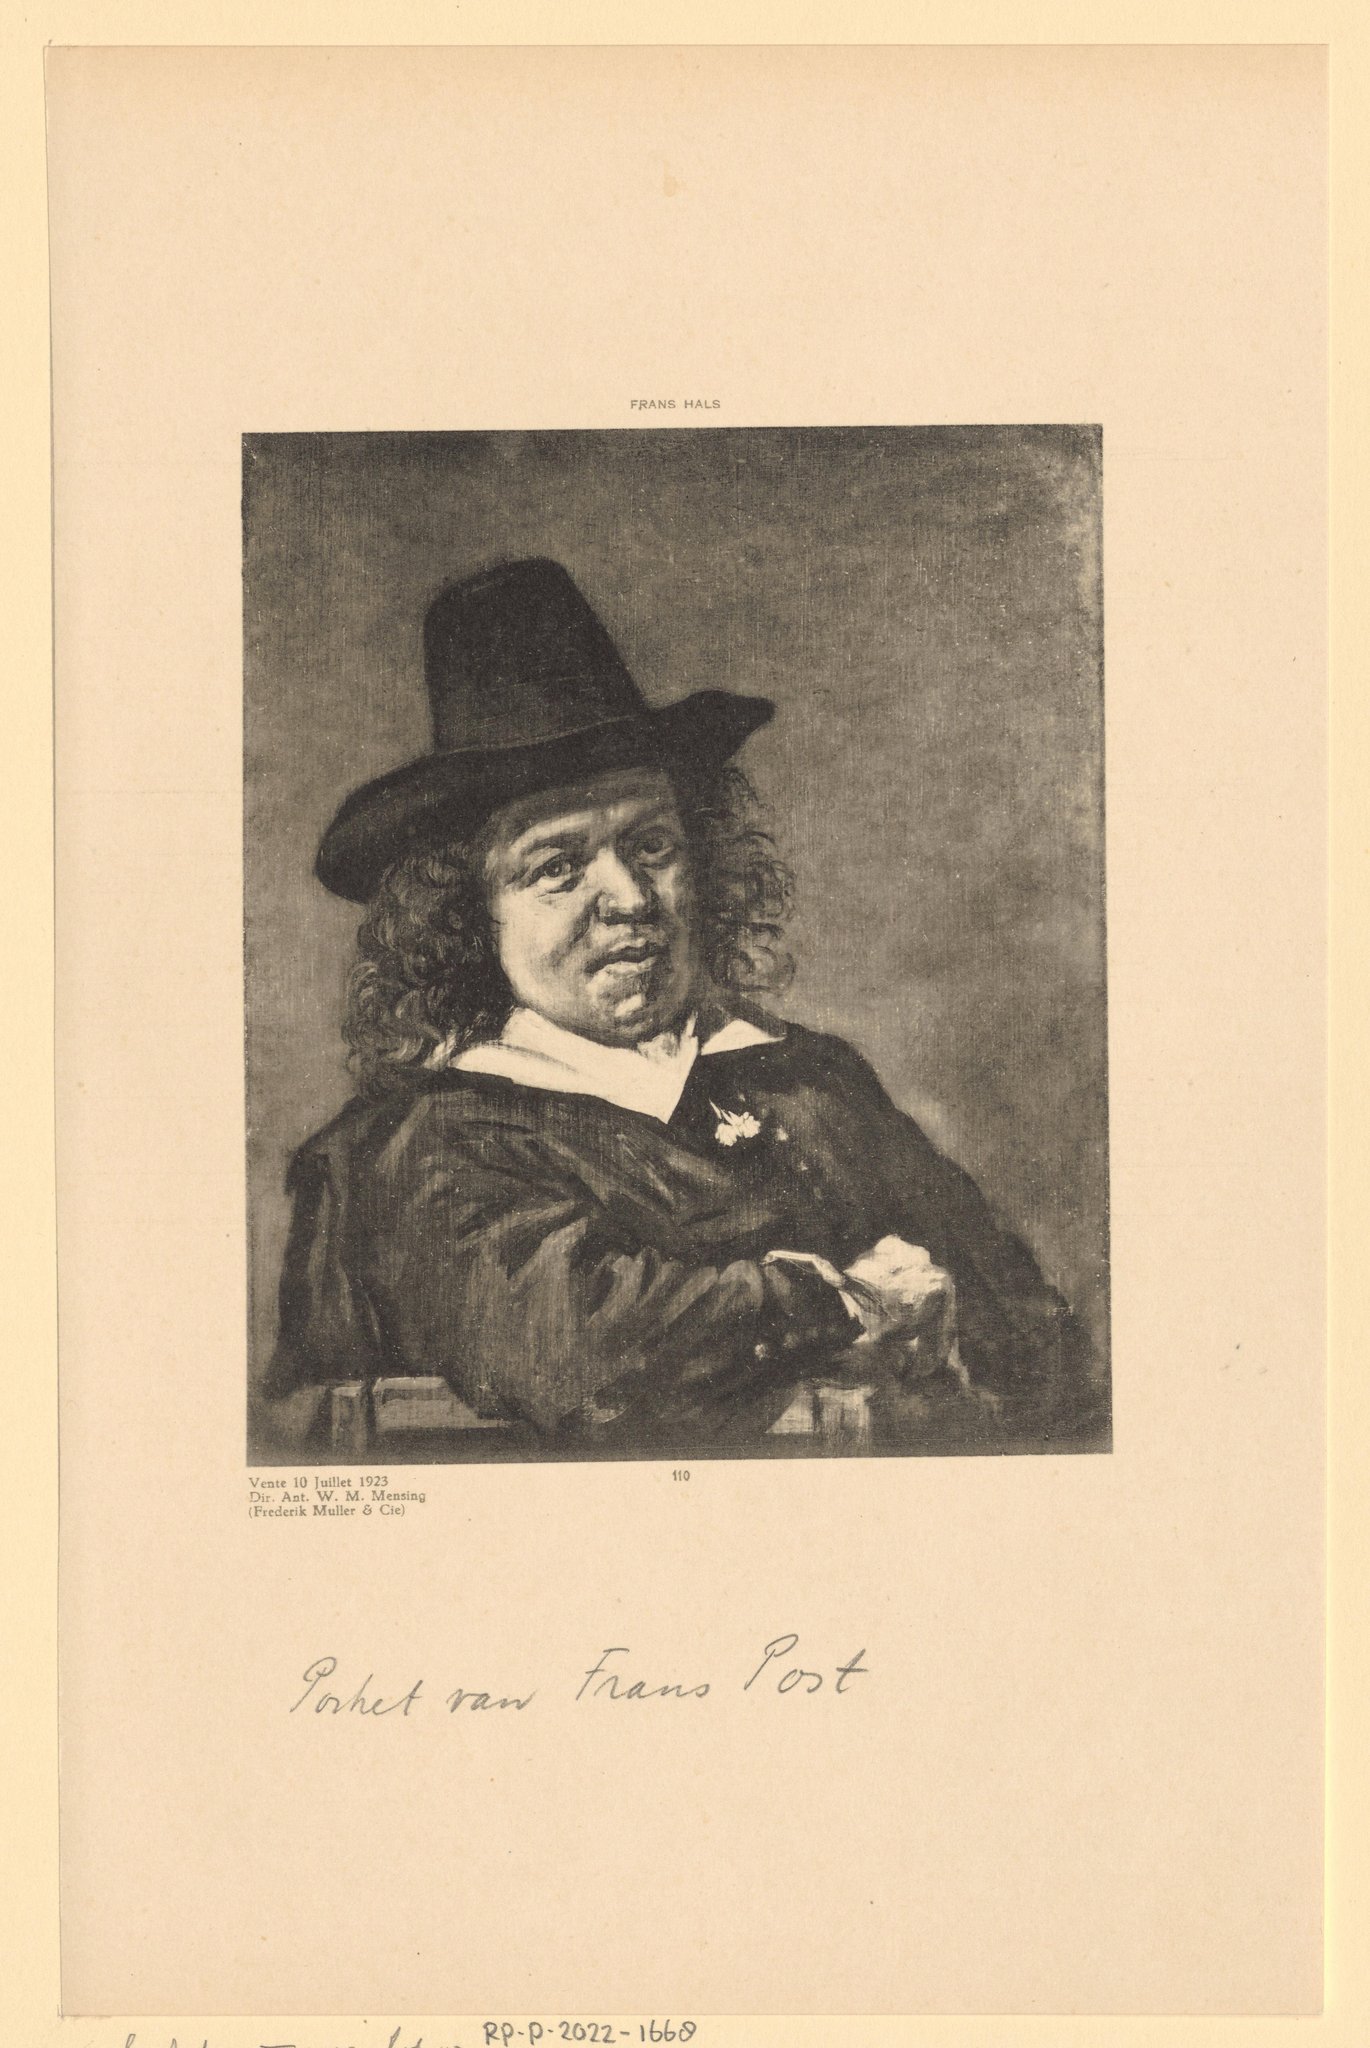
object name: photomechanical print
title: Portret van Frans Post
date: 1875-1930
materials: paper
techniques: photograph, letterpress printing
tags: painter, frans jansz post, historical persons, portrait, self-portrait of painter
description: Fotomechanische afdruk uit een onbekende publicatie.